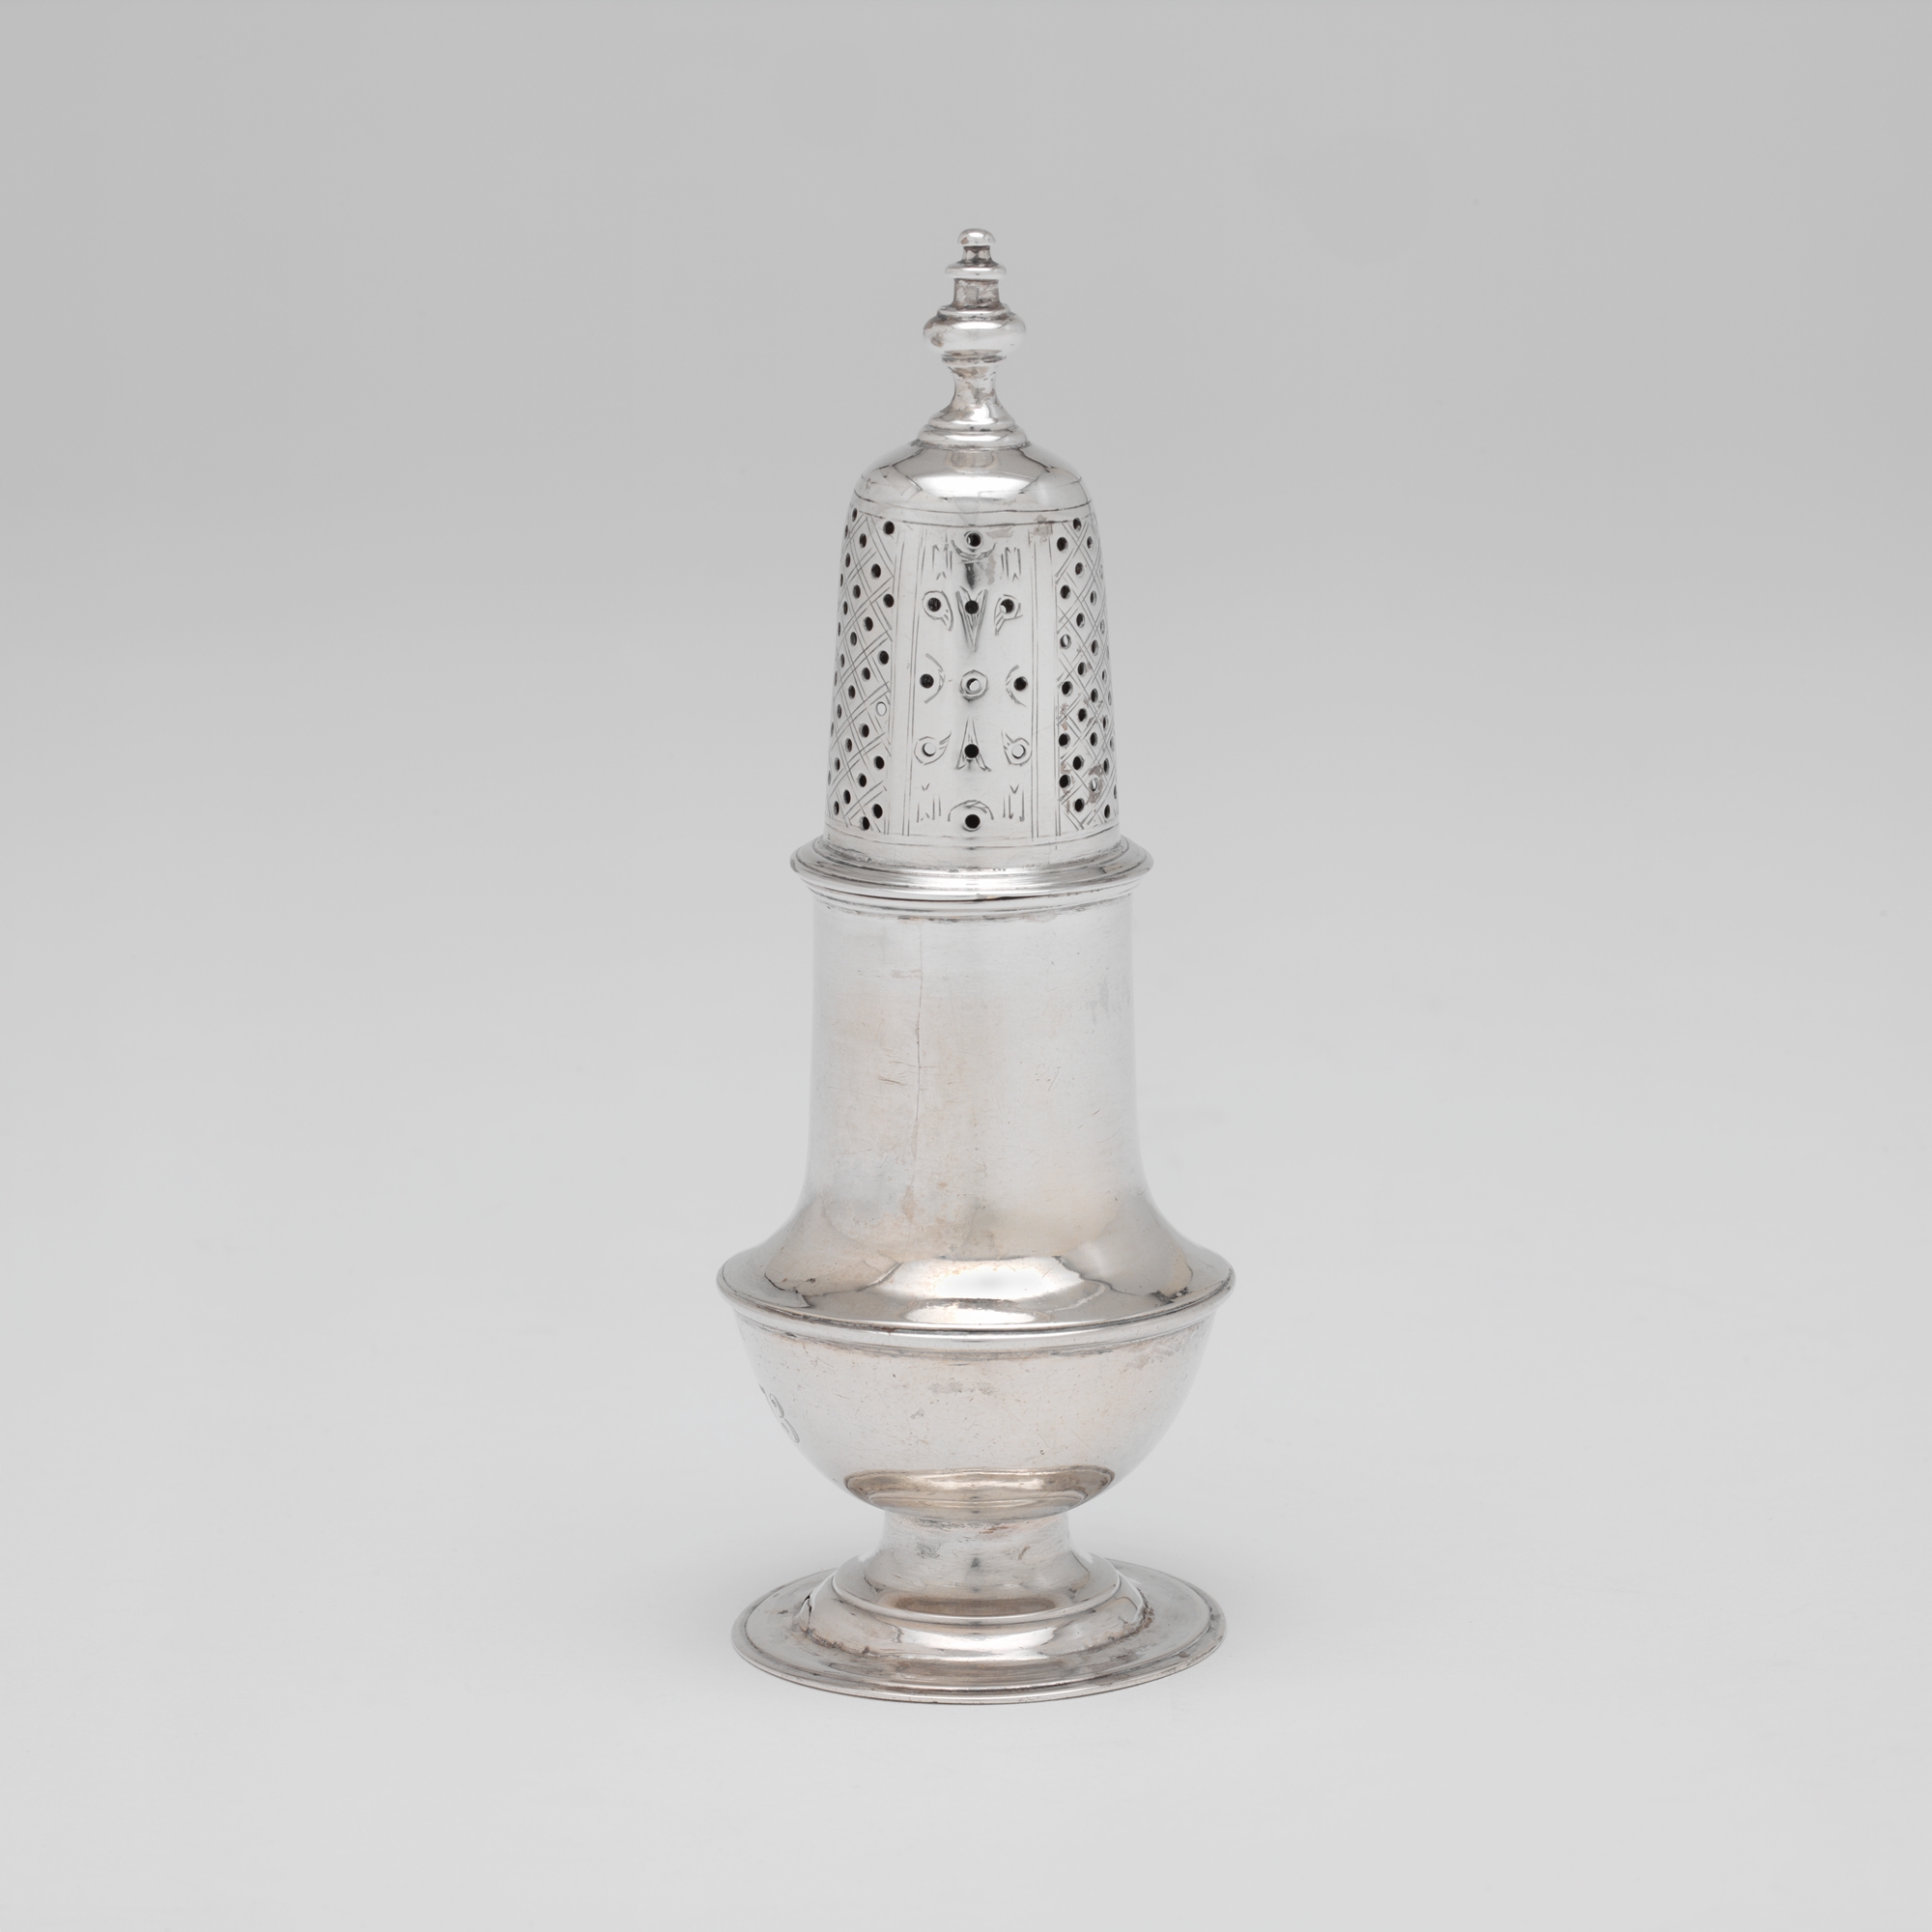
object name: caster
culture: american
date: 1773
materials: silver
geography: united states